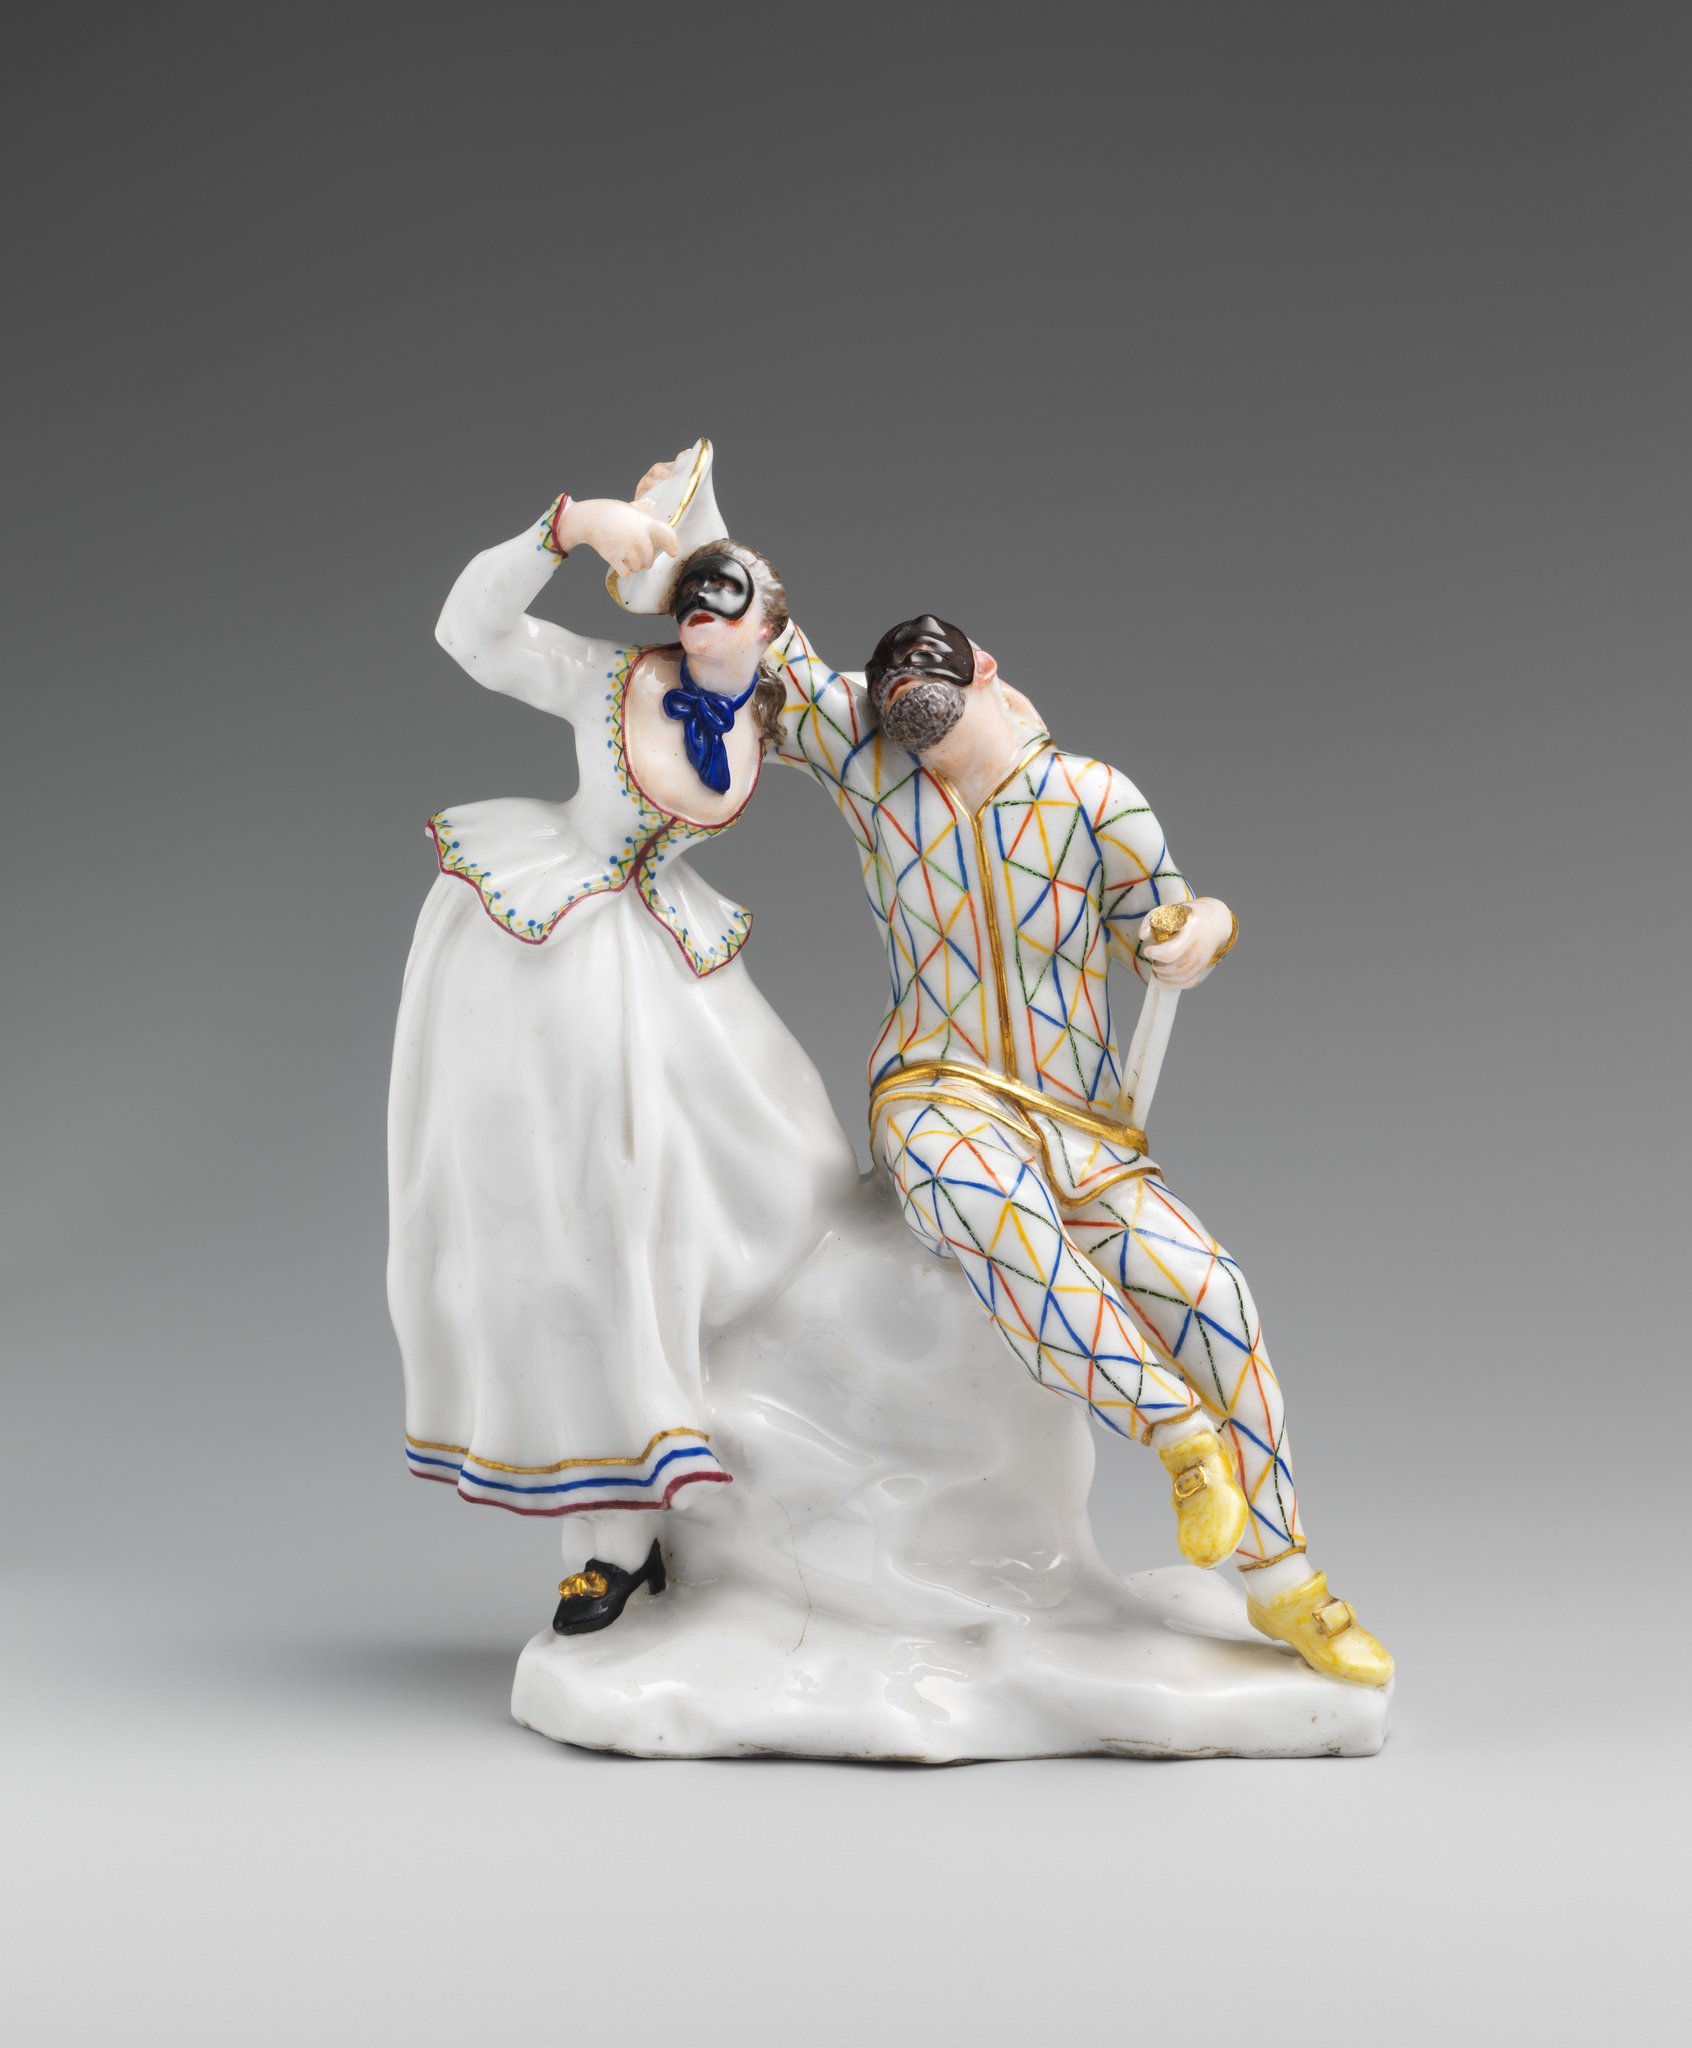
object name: figure group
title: Harlequin and Columbine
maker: capodimonte porcelain manufactory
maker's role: manufactory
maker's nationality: italian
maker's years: 1740-1759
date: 1745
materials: soft paste porcelain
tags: men,women